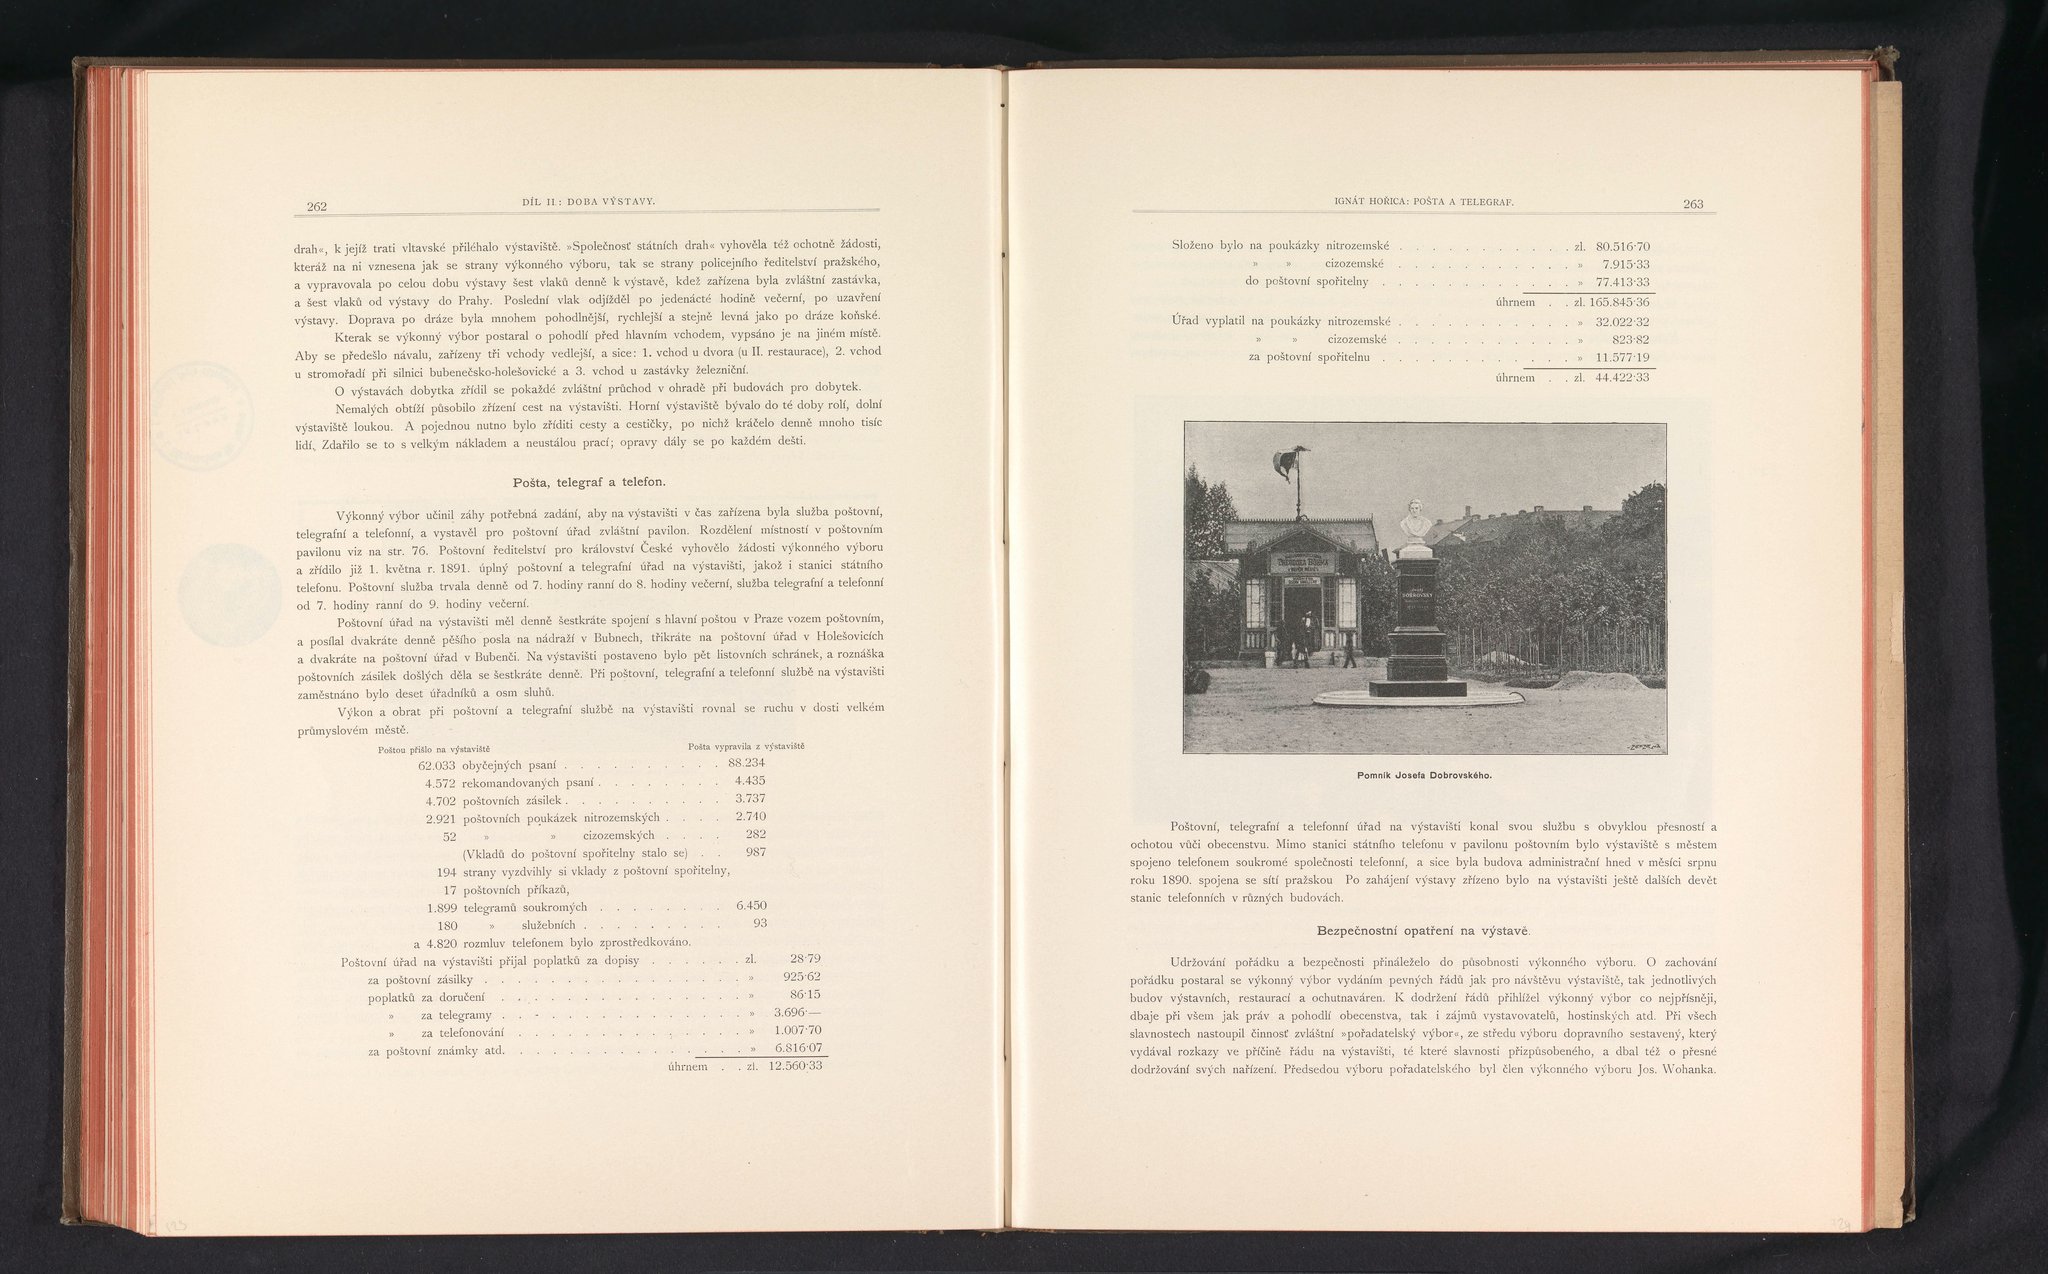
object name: page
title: Pomnik Josefa Dobrovského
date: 1891-1893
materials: paper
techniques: autotype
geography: prague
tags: façade (of house or building), restaurant